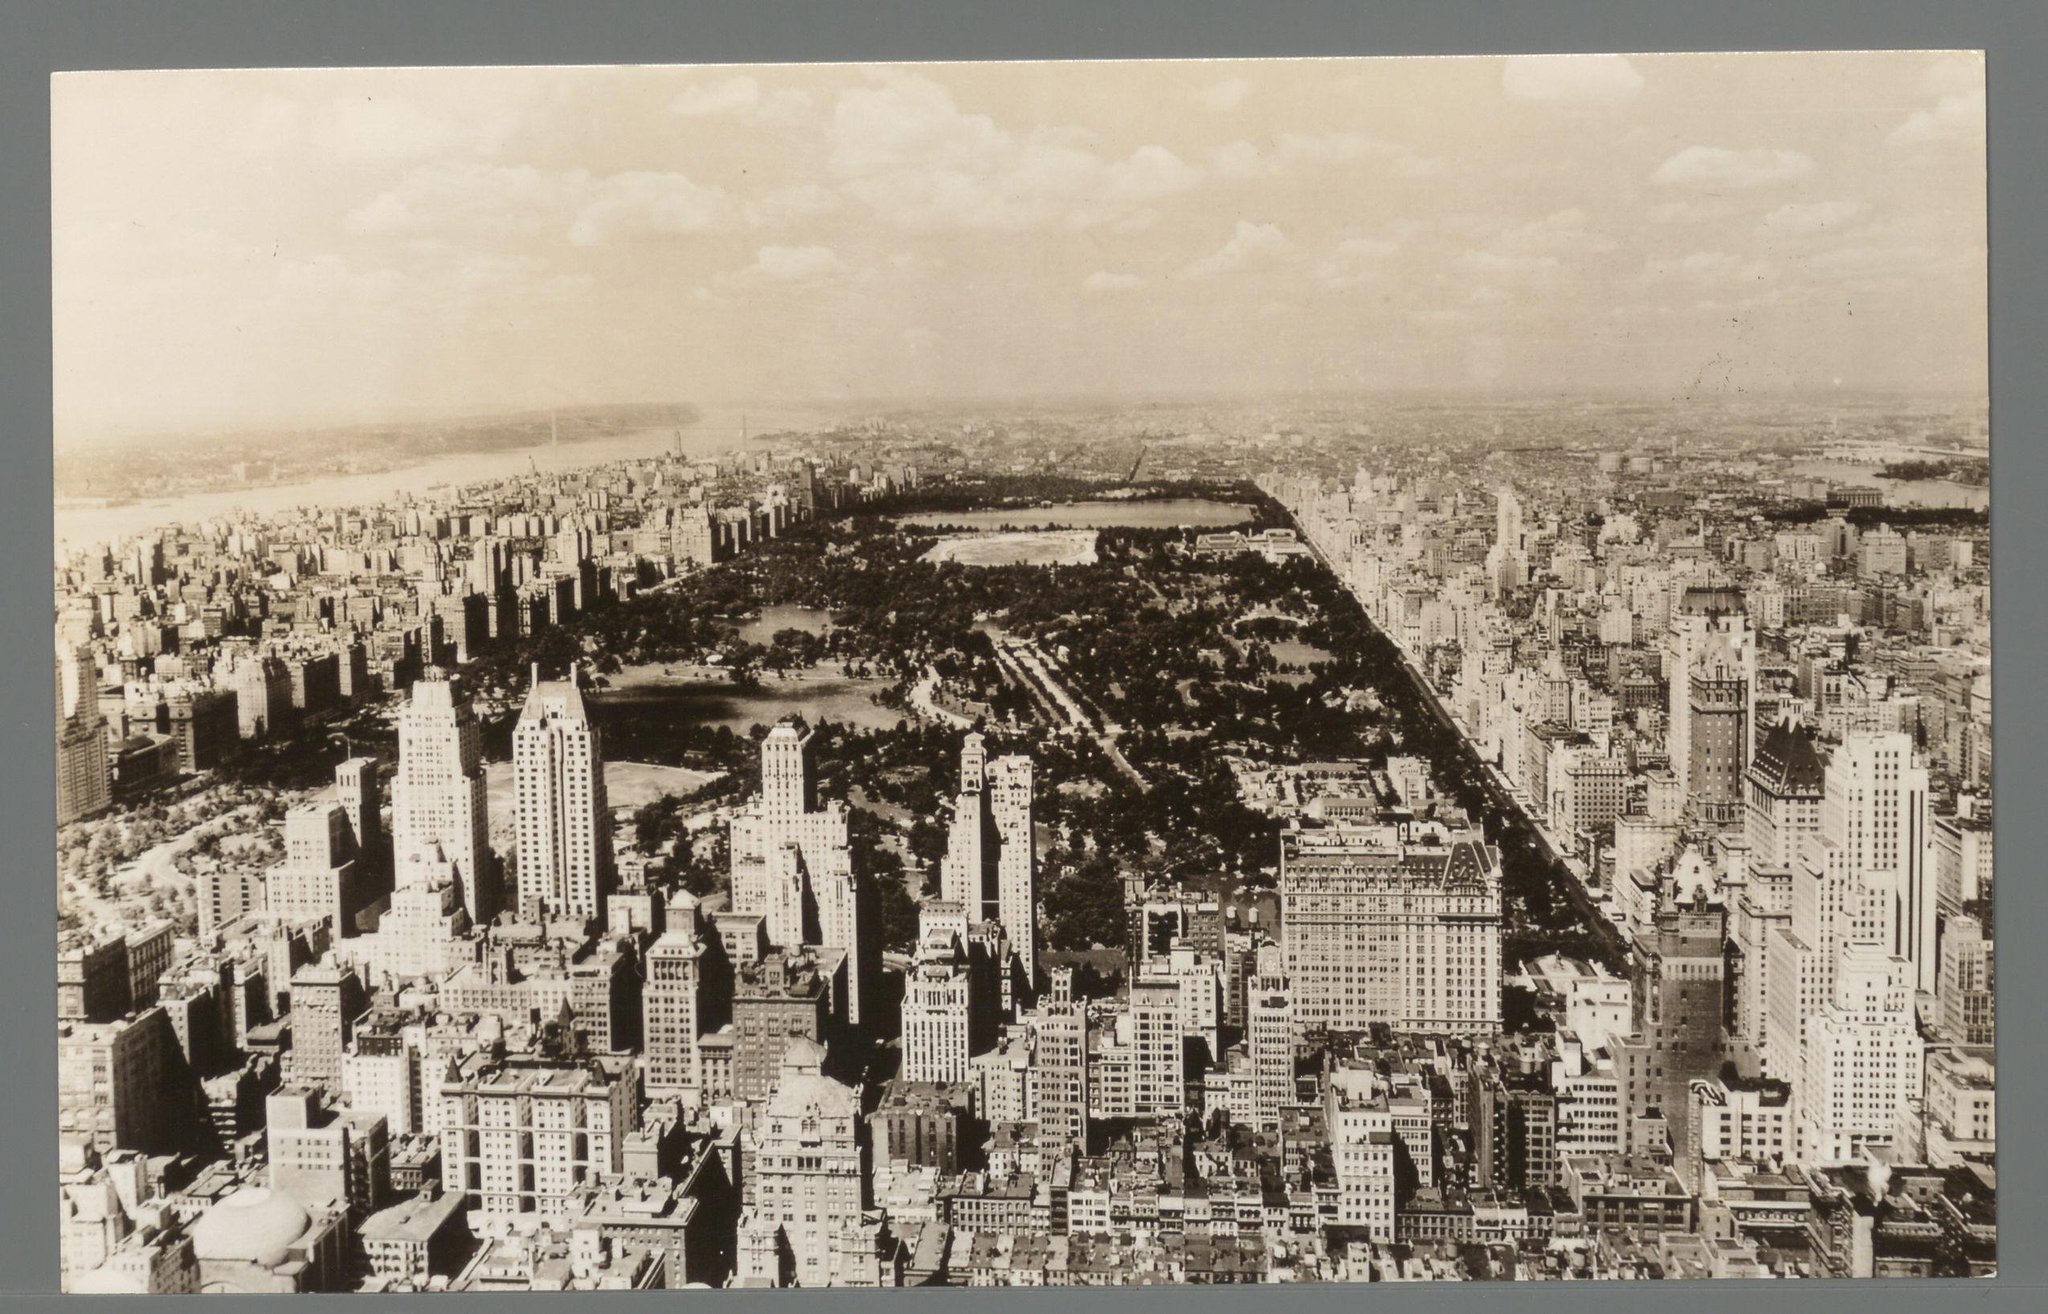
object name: ansichtkaart, prentbriefkaart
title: Rockefeller Center. Looking north from the 70th floor of the RCA Building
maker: e. ratcliffe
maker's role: fotograaf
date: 1930-1950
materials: photographic support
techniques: photography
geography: new york city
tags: prospect of city, town panorama, silhouette of city, manhattan